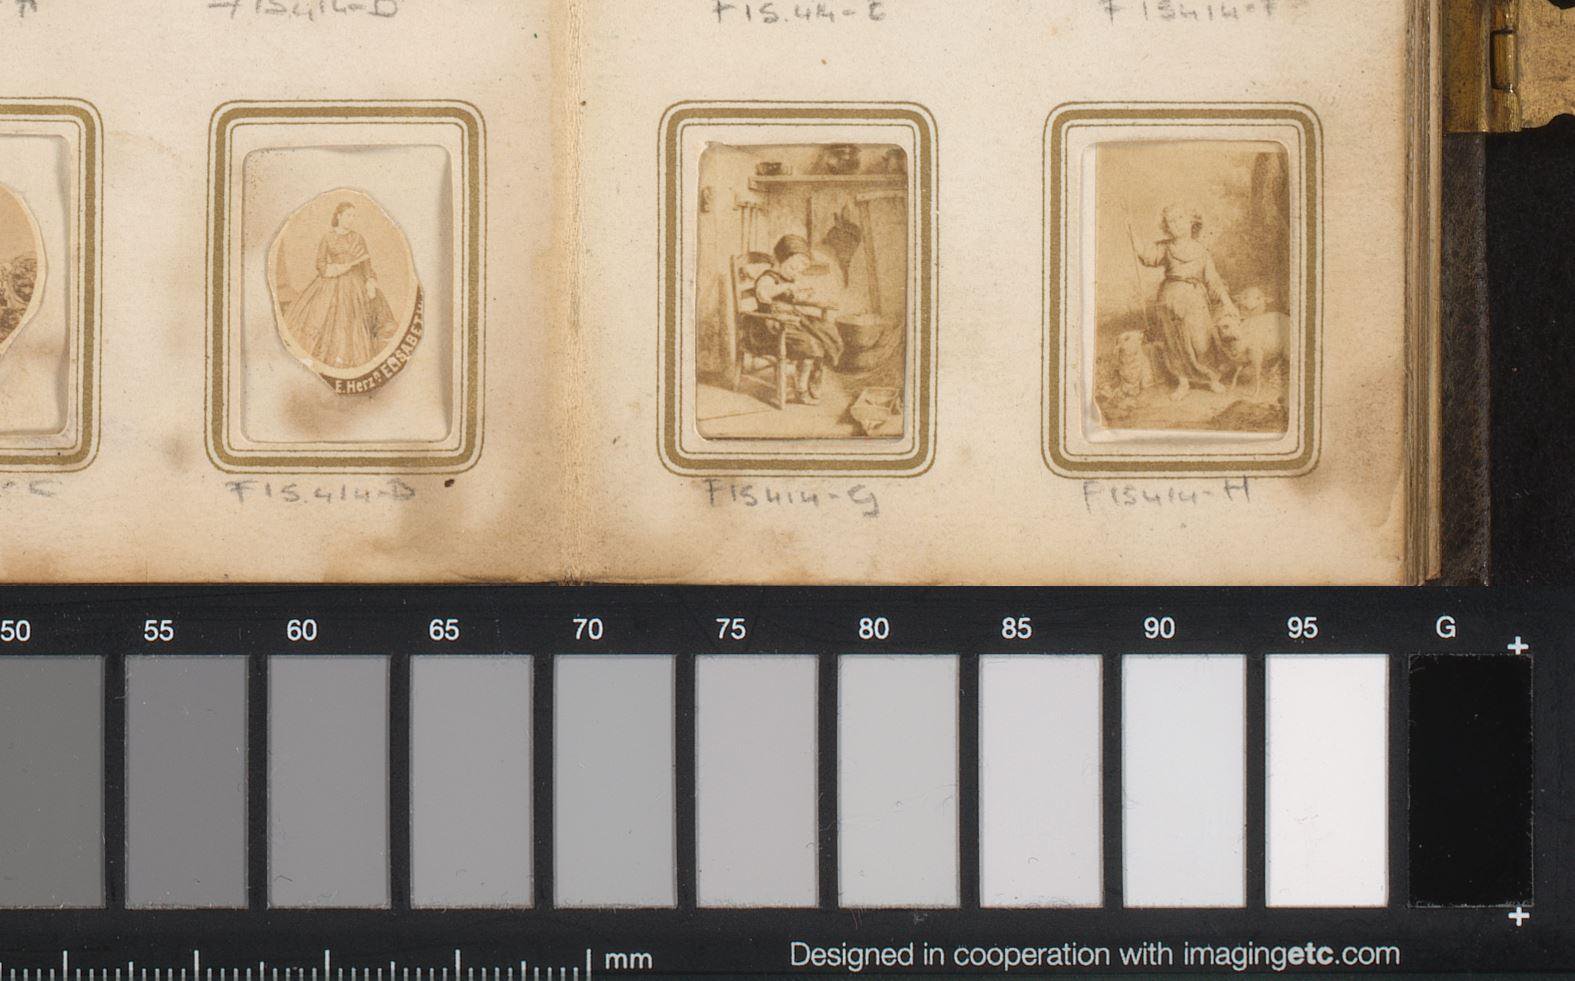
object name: photograph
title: Fotoreproductie van een onbekend meisje op een stoel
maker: Anonymous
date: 1851-1900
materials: paper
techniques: albumen print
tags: girl (child between toddler and youth)